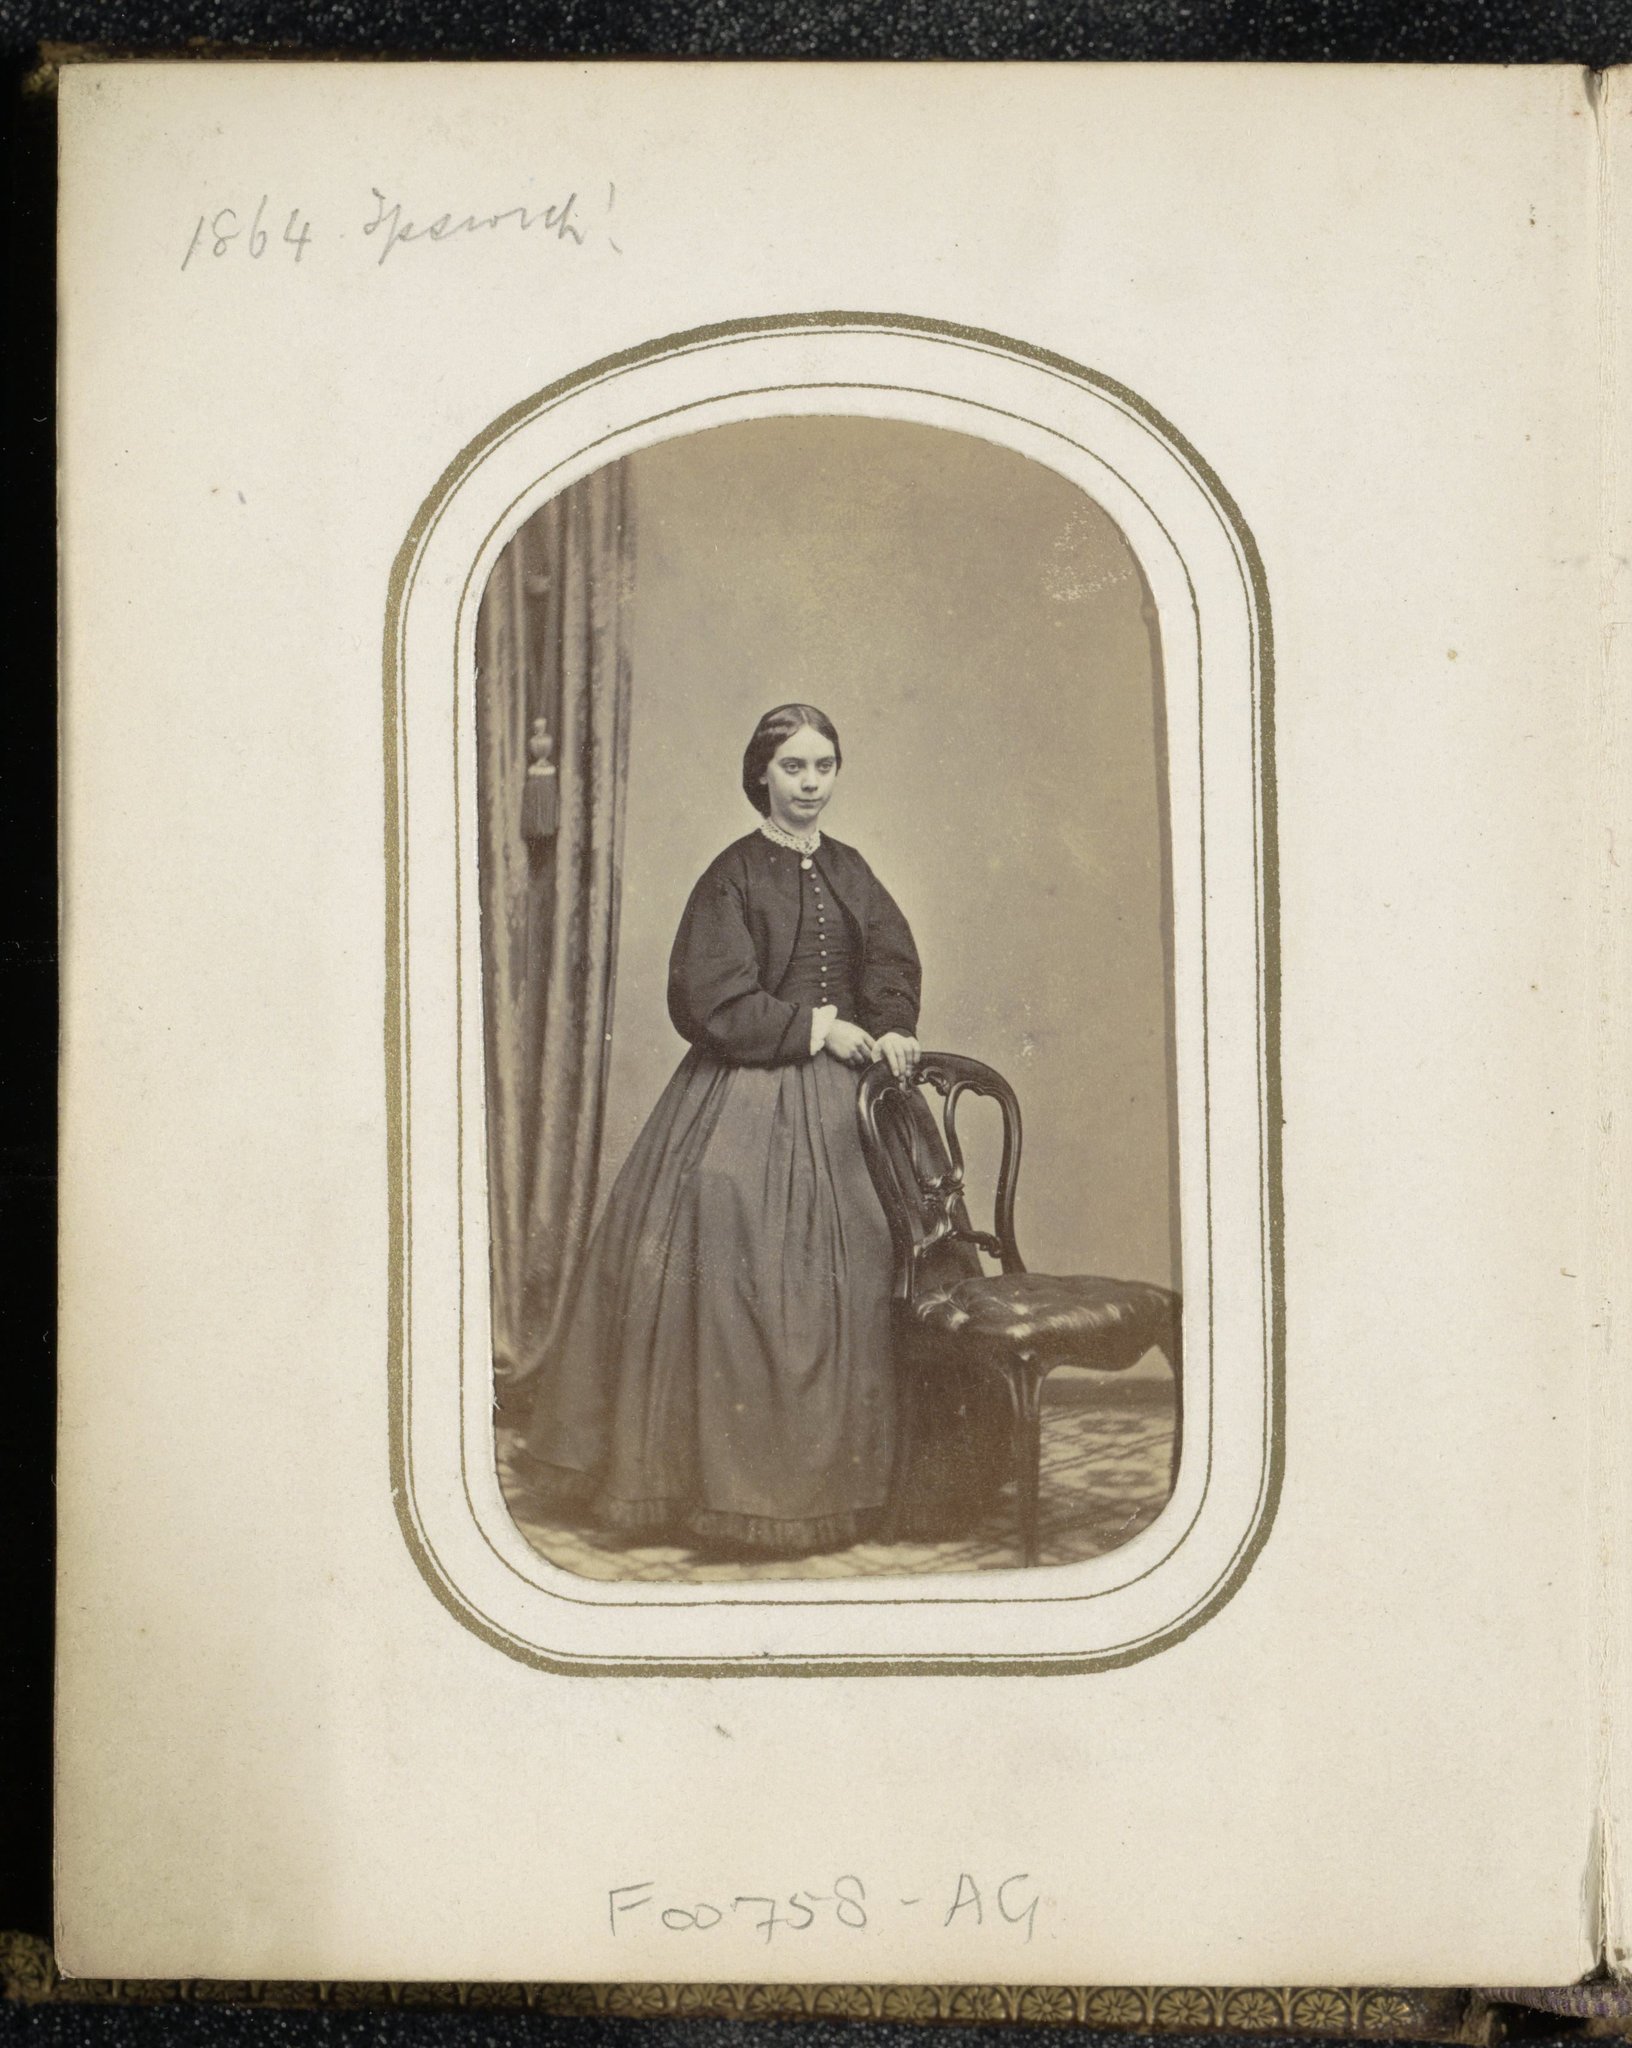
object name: carte de visite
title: Portret van een vrouw bij een stoel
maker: john wright gilmor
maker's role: fotograaf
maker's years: 1815-1898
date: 1801-1864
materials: cardboard, paper, photographic support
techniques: albumen print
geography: colchester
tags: studio requisites ~ photographer, clothing for the lower part of the body, historical persons, styles of hairdress - aa - ~ women, clothing for the upper part of the body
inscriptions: inscription: ‘1864 Ipswhich!’, address: ‘Colchester, 29 Head Street’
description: Onderdeel van Engels fotoalbum van E.A. Kettle met 42 cartes-de-visite.